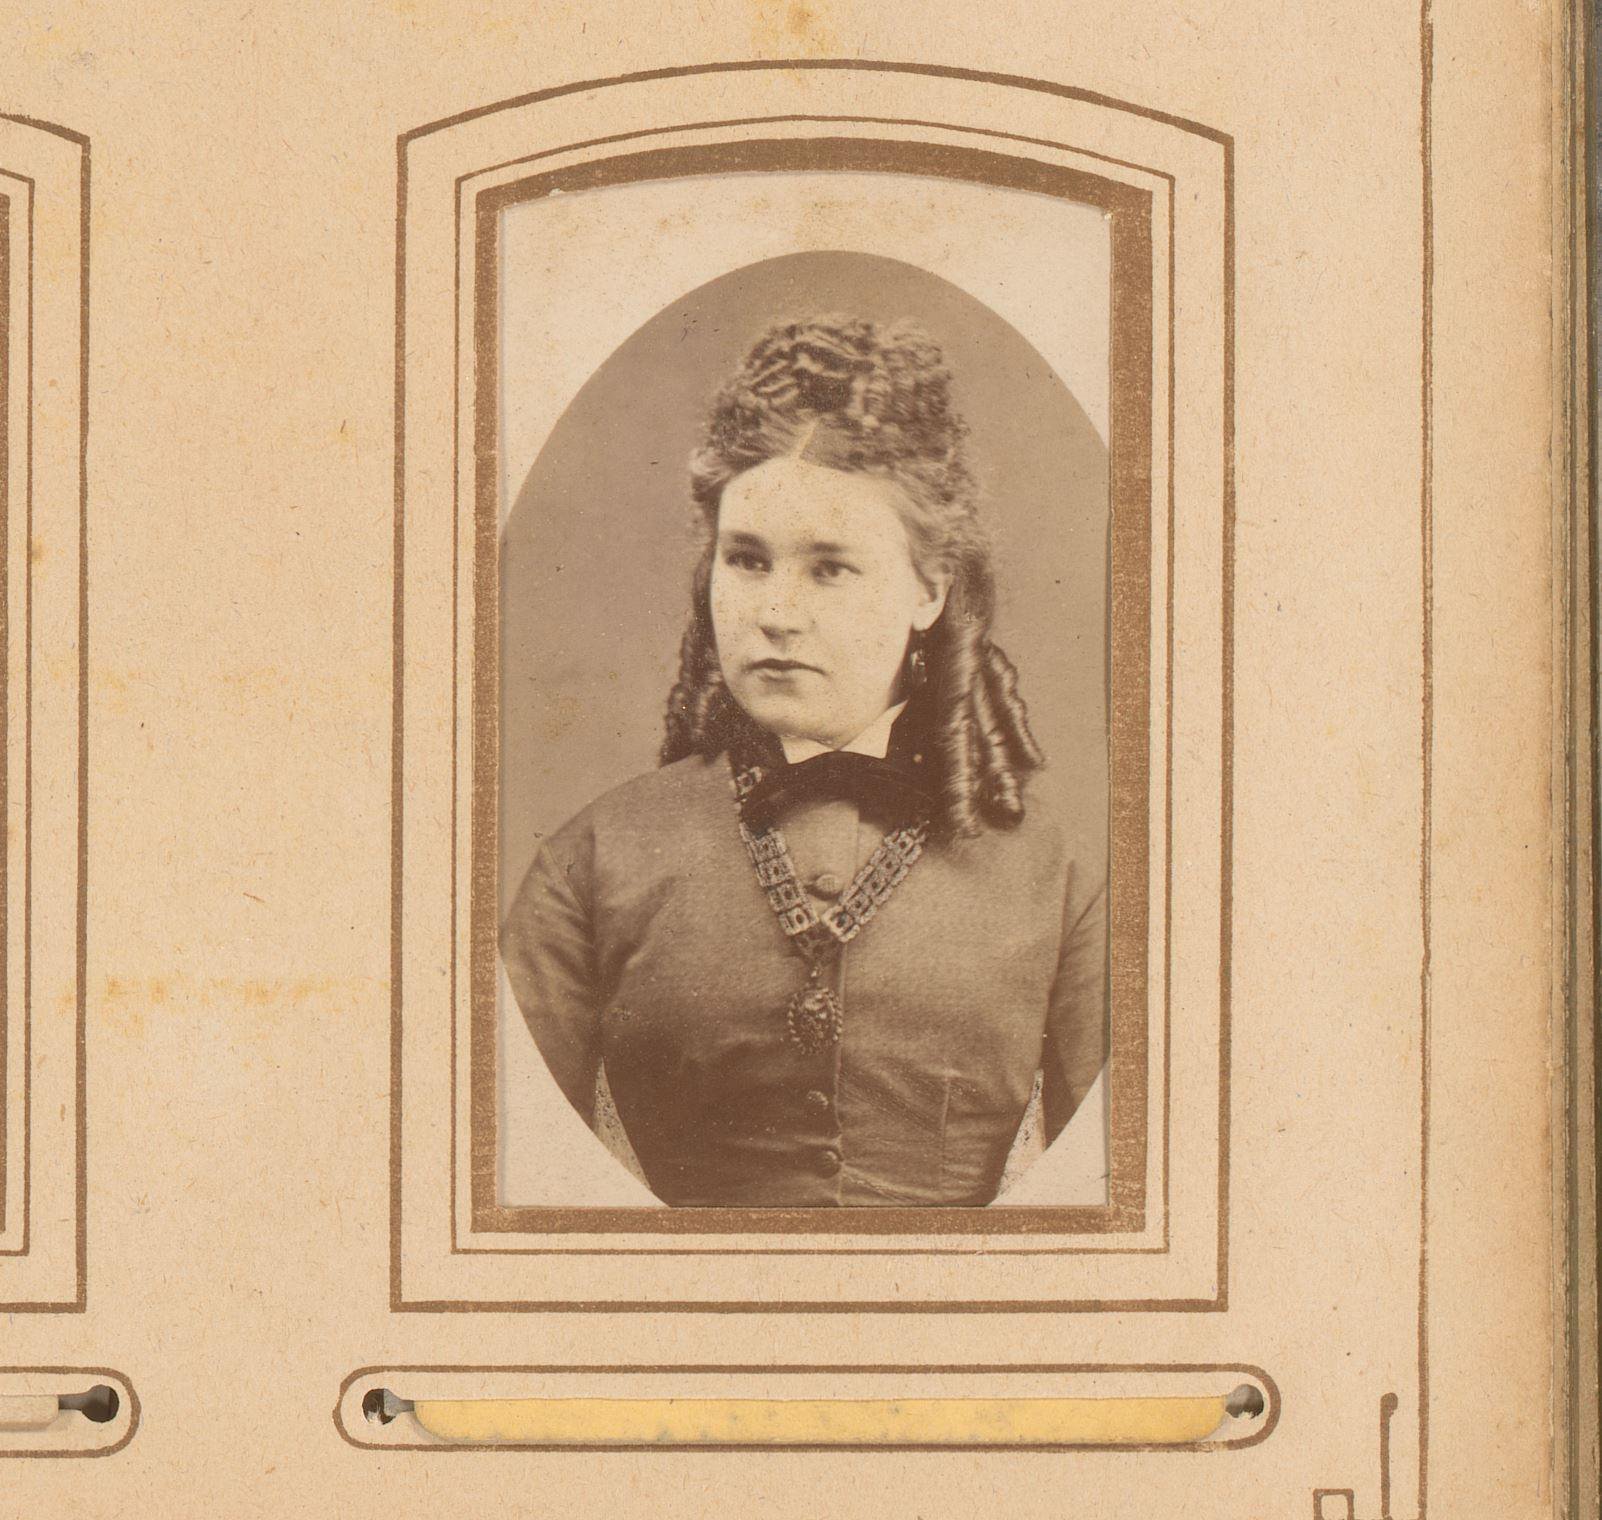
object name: carte de visite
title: Portret van een vrouw met een ketting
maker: jan goedeljee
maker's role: fotograaf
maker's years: 1824-1905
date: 1865-1879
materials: cardboard, photographic support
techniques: albumen print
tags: adult woman, historical persons, necklace